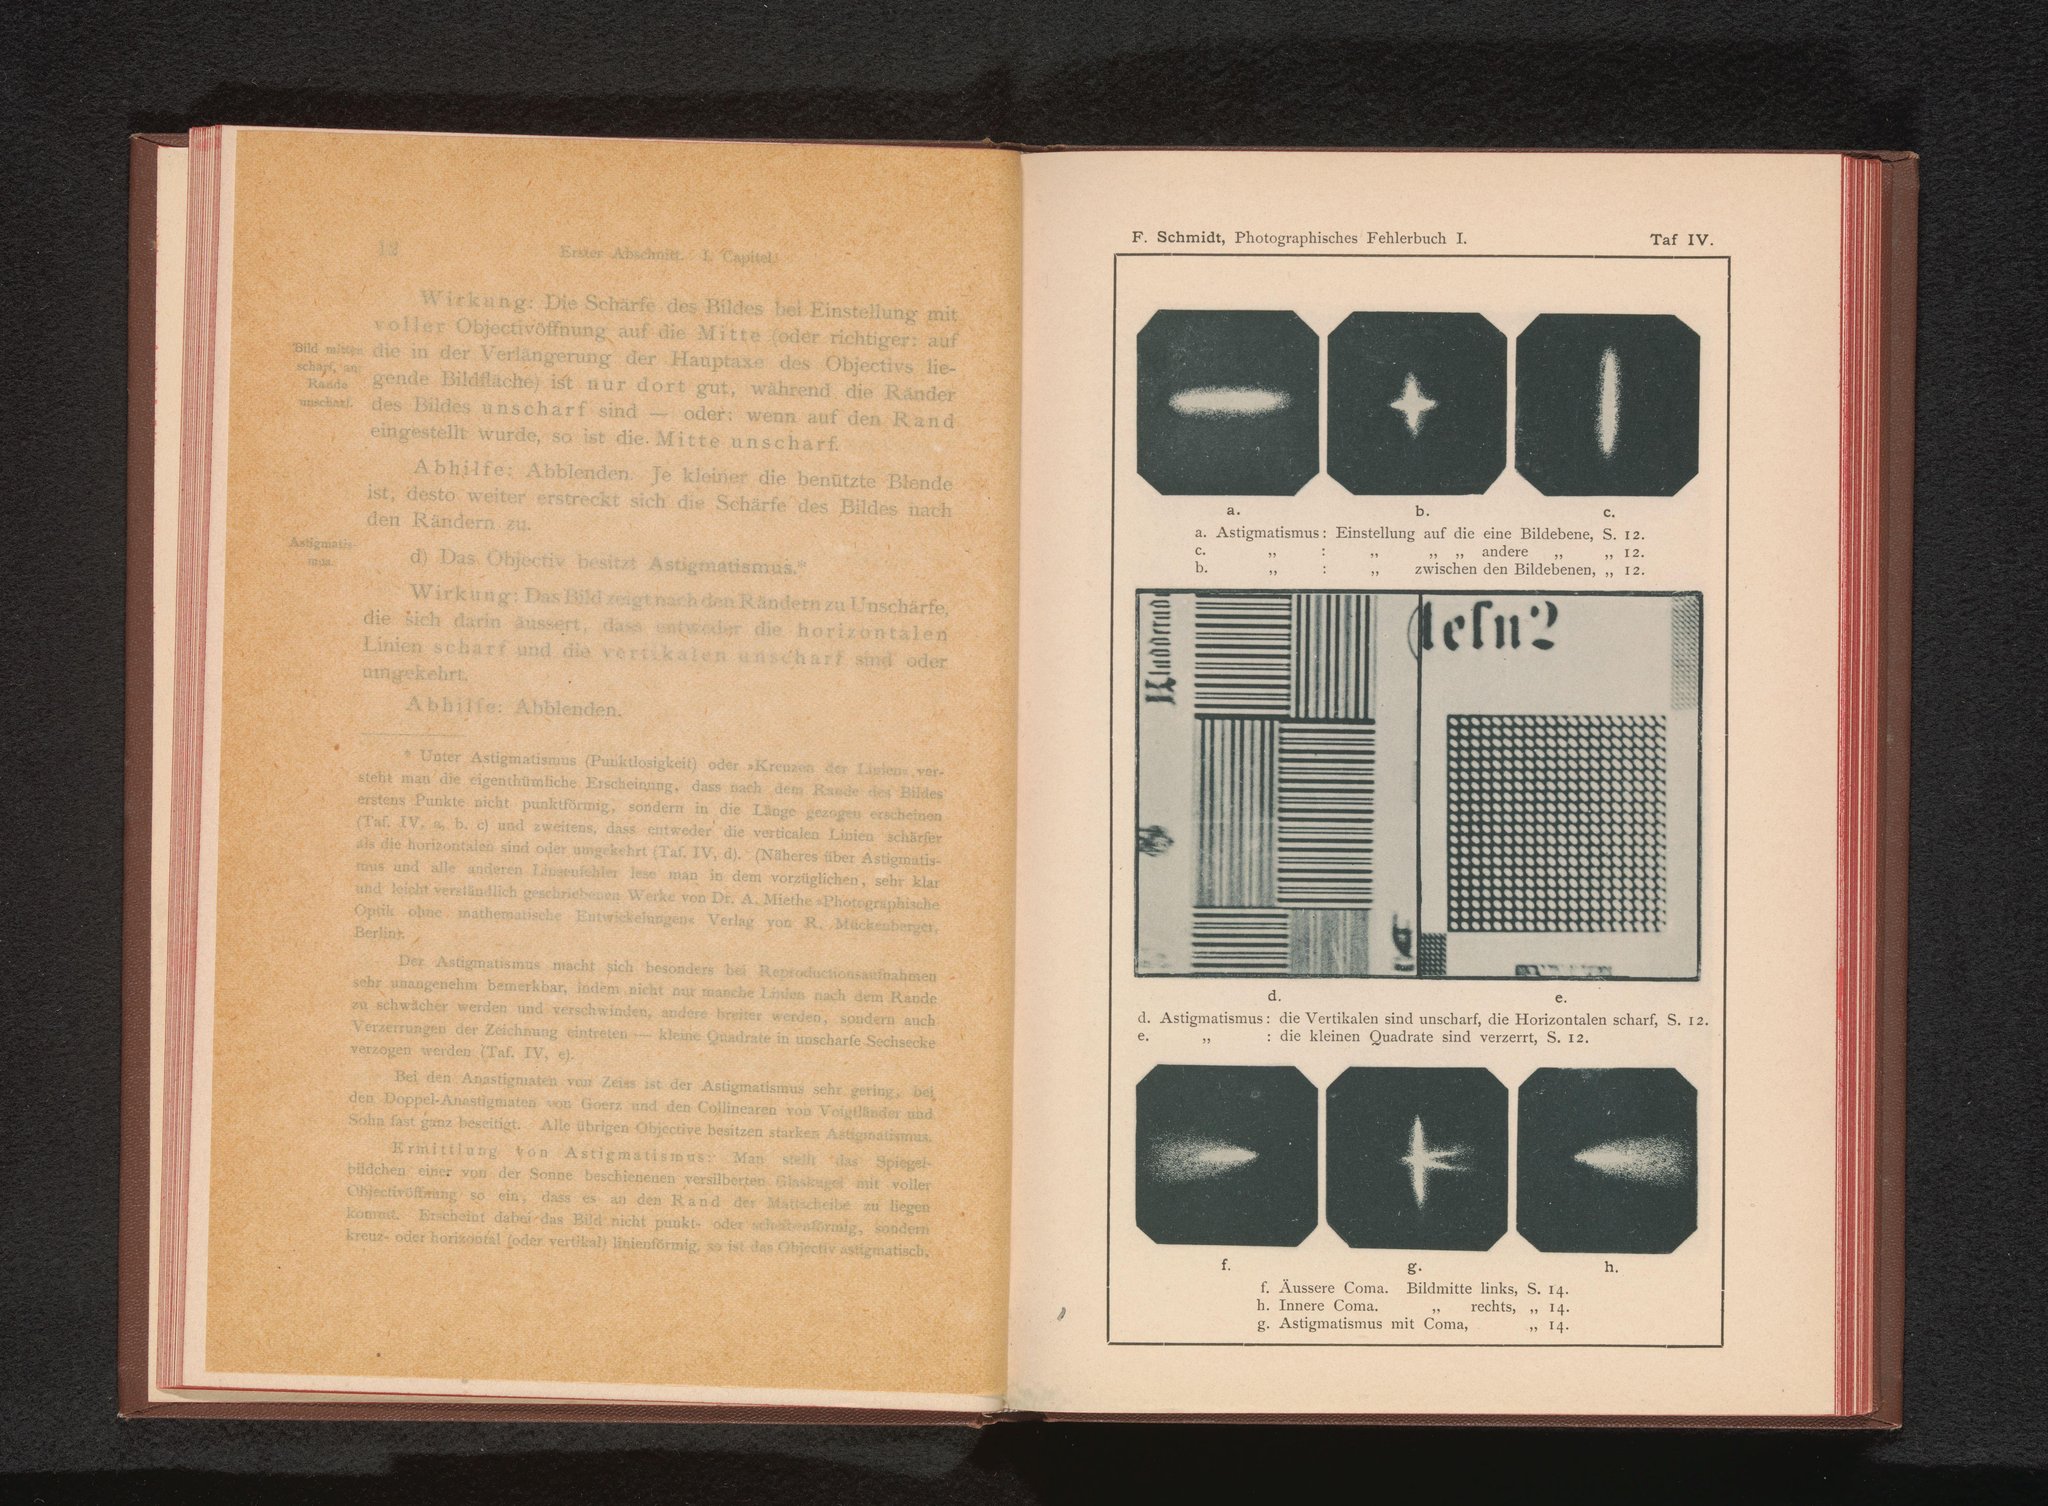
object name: photomechanical print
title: Zeven voorbeelden van vervormingen die optreden door een niet geheel ronde lens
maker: Anonymous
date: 1890-1895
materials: paper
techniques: photograph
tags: distortion, refraction (optics)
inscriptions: number: ‘Taf. IV.’, inscription: ‘a. b. c./ a. Astigmatismus : Einstellung auf die eine Bildebene, S. 12./ c. ,, : ,, ,, ,, andere ,, ,, 12./ b. ,, : ,, zwischen den Bildebene ,, 12./ d. e./ d. Astigmatismus : die Vertikalen sind unscharf, die Horizontalen scharf, S. 12./ e. ,, : die kleinen Quadrate sind verzerrt, S. 12./ f. g. h./ f. Äussere Coma. Bildmitte links, S. 14./ h. Innere Coma. ,, rechts, ,, 14./ g. Astigmatismus mit Coma, ,, 14.’